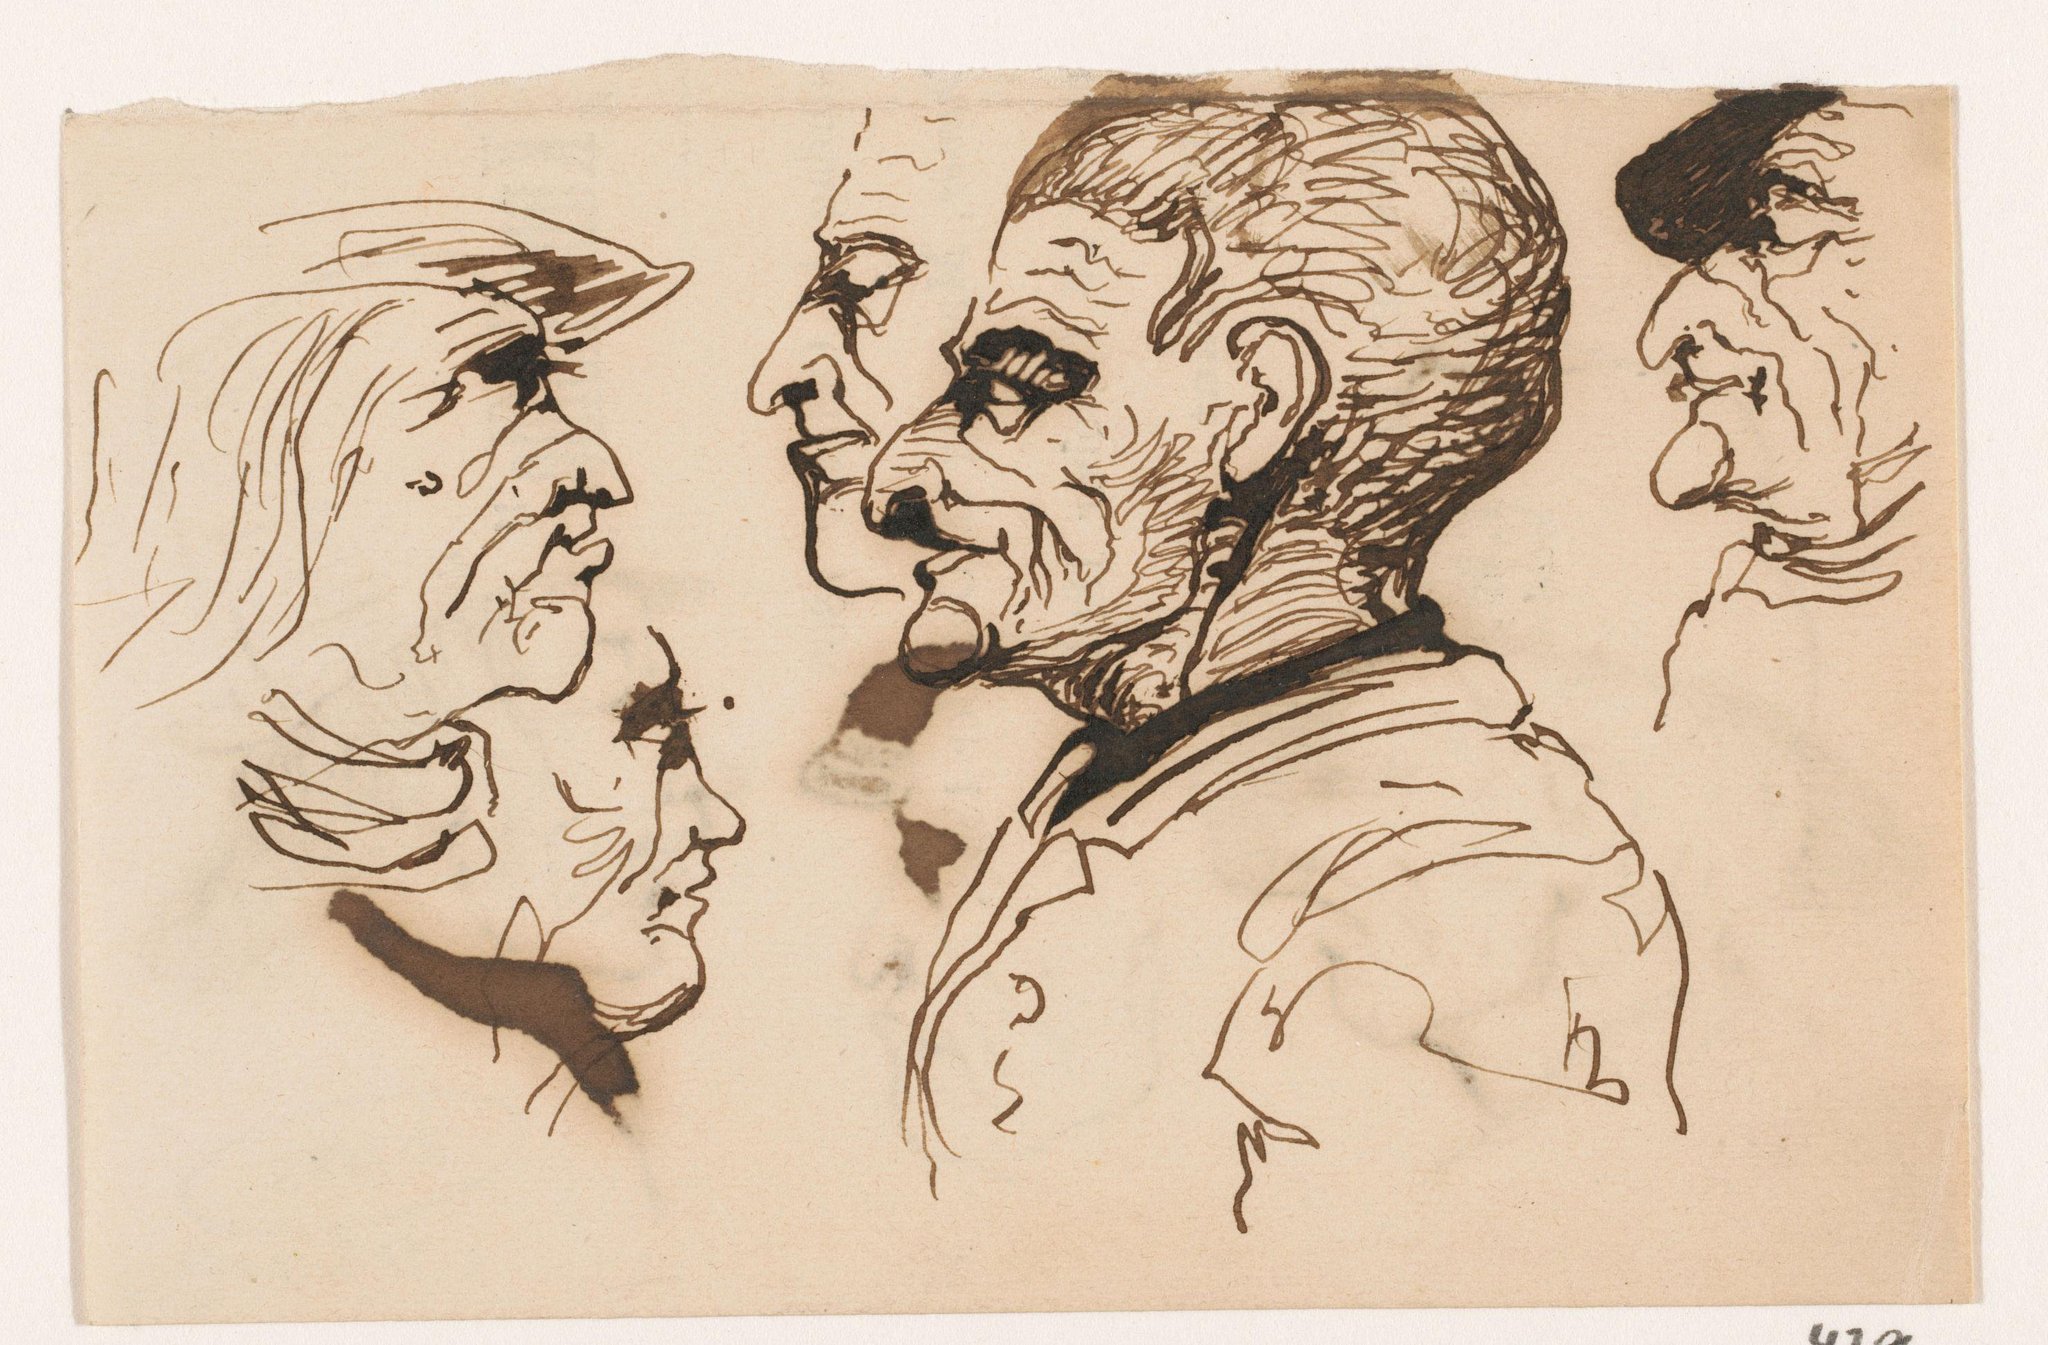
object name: drawing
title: Koppen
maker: johannes tavenraat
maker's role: draughtsman, painter, print maker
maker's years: 1809-1881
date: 1868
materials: ink, paper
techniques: brush, pen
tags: caricatures (human types)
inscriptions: collector's mark: Lugt 2228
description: Vijf koppen. Getekend op de achterzijde van een drukwerk uit 1868.